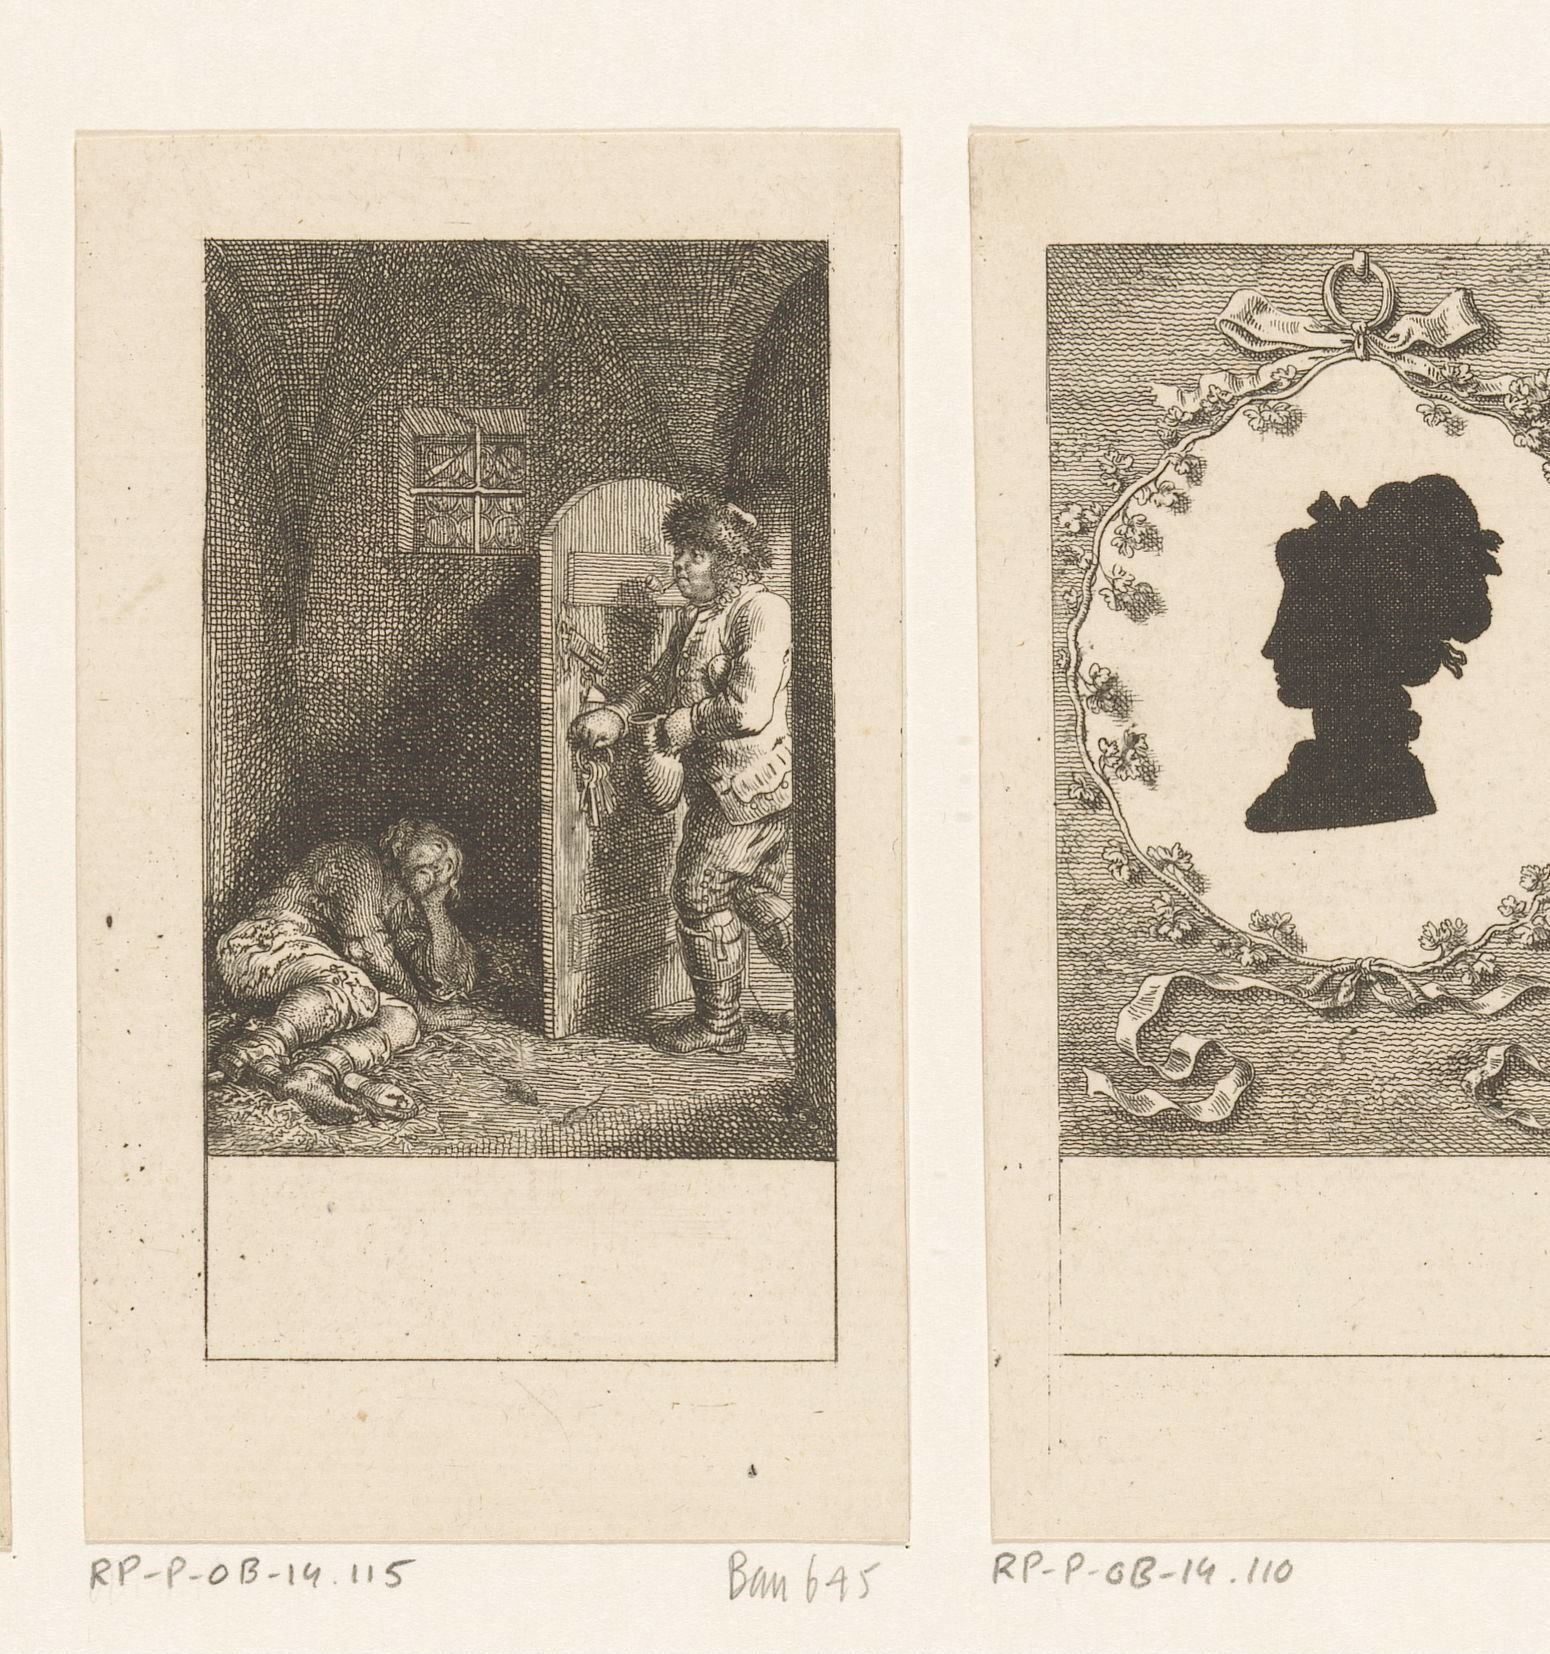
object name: print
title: Gevangene en cipier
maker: daniel nikolaus chodowiecki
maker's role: draughtsman, print maker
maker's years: 1726-1801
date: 1779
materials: paper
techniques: etching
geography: berlin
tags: prison, jail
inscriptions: collector's mark: Lugt 2228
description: Negende prent afkomstig uit een serie van twaalf verschillende prenten. De scènes zijn op een plaat geëtst. Een latere staat van deze serie is ook gebruikt in: Lauenburger genealogischen Kalender auf das Jahr 1780.